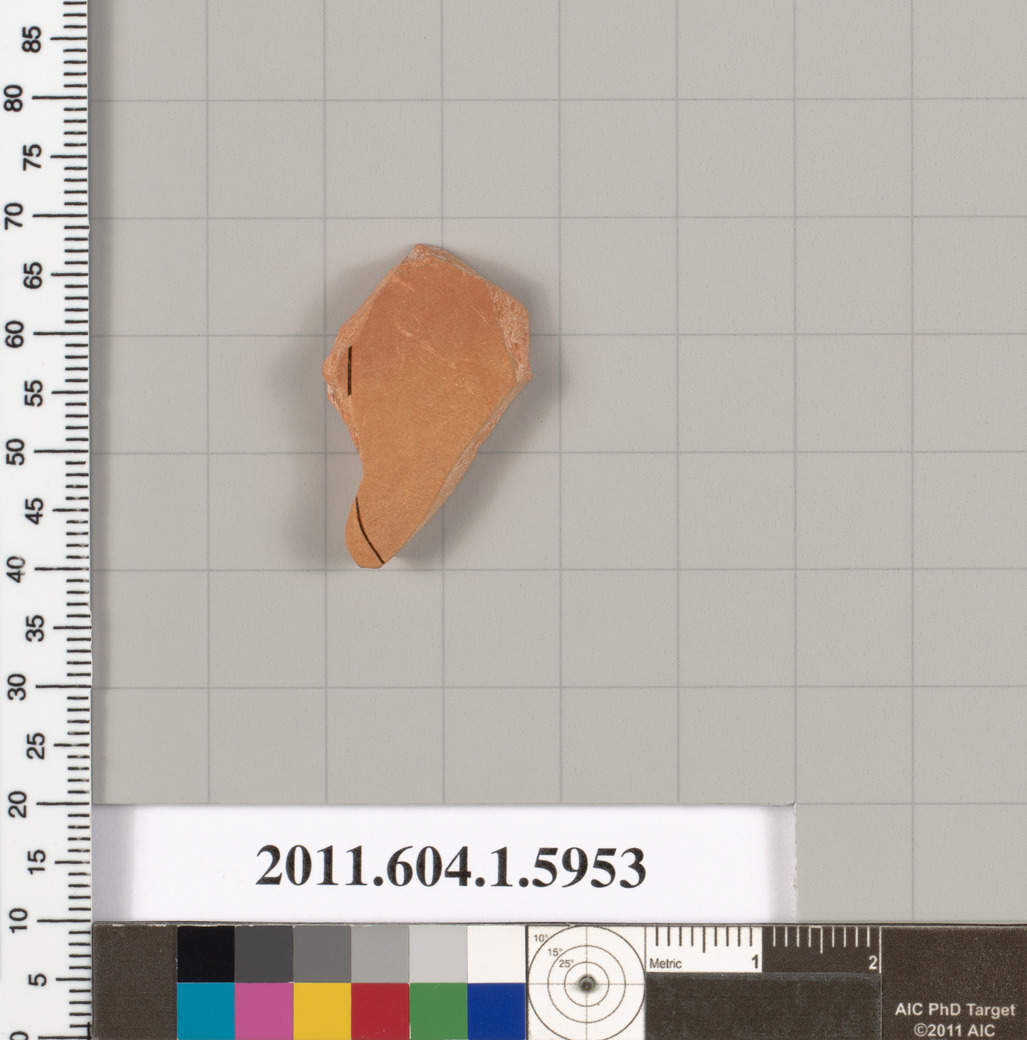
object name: kylix fragment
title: Terracotta fragment of a kylix (drinking cup)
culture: greek, attic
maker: skythes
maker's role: artist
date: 433-567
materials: terracotta